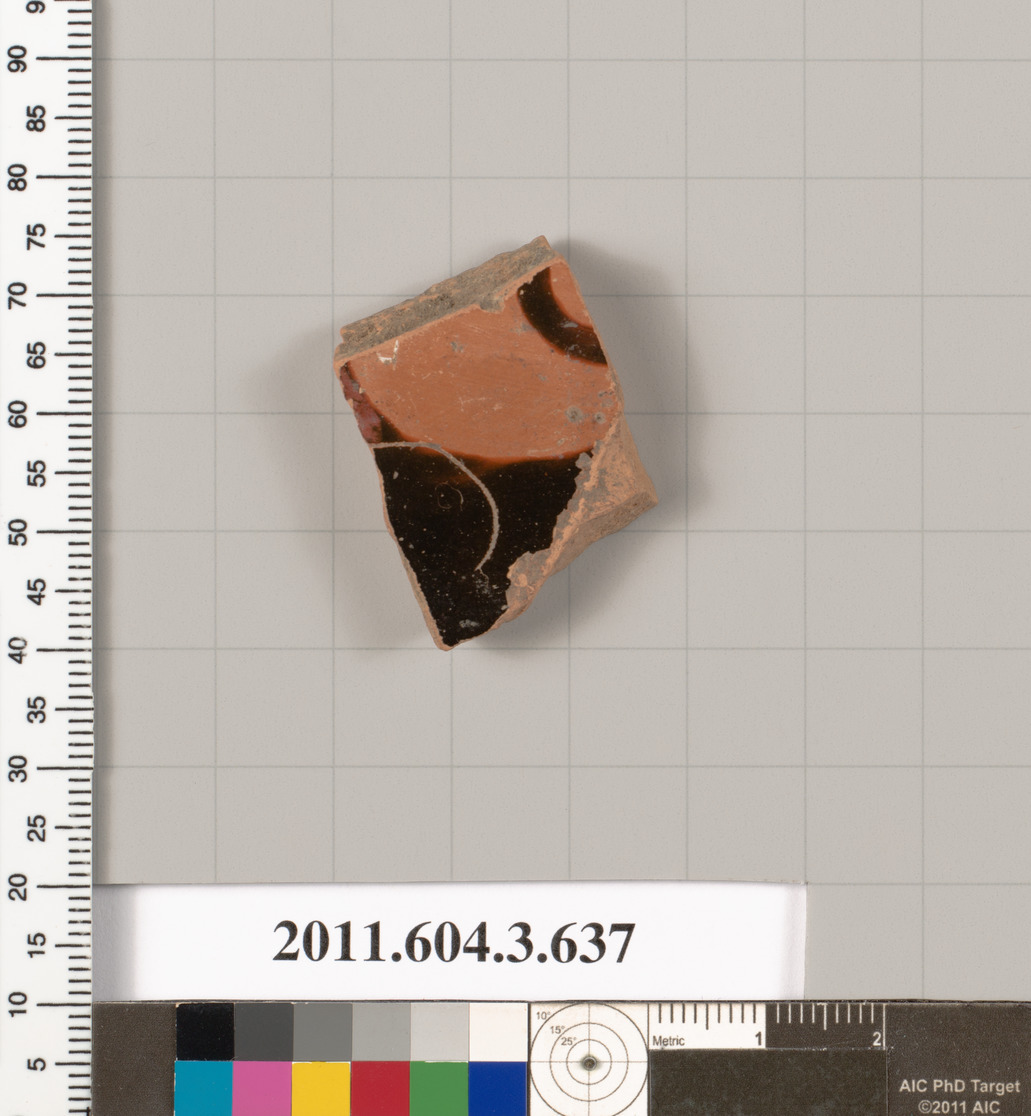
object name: calyx krater or column krater fragment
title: Terracotta fragment of a calyx-krater (bowl for mixing wine and water) or column-krater (bowl for mixing wine and water)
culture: greek, attic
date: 450-401 BCE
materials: terracotta